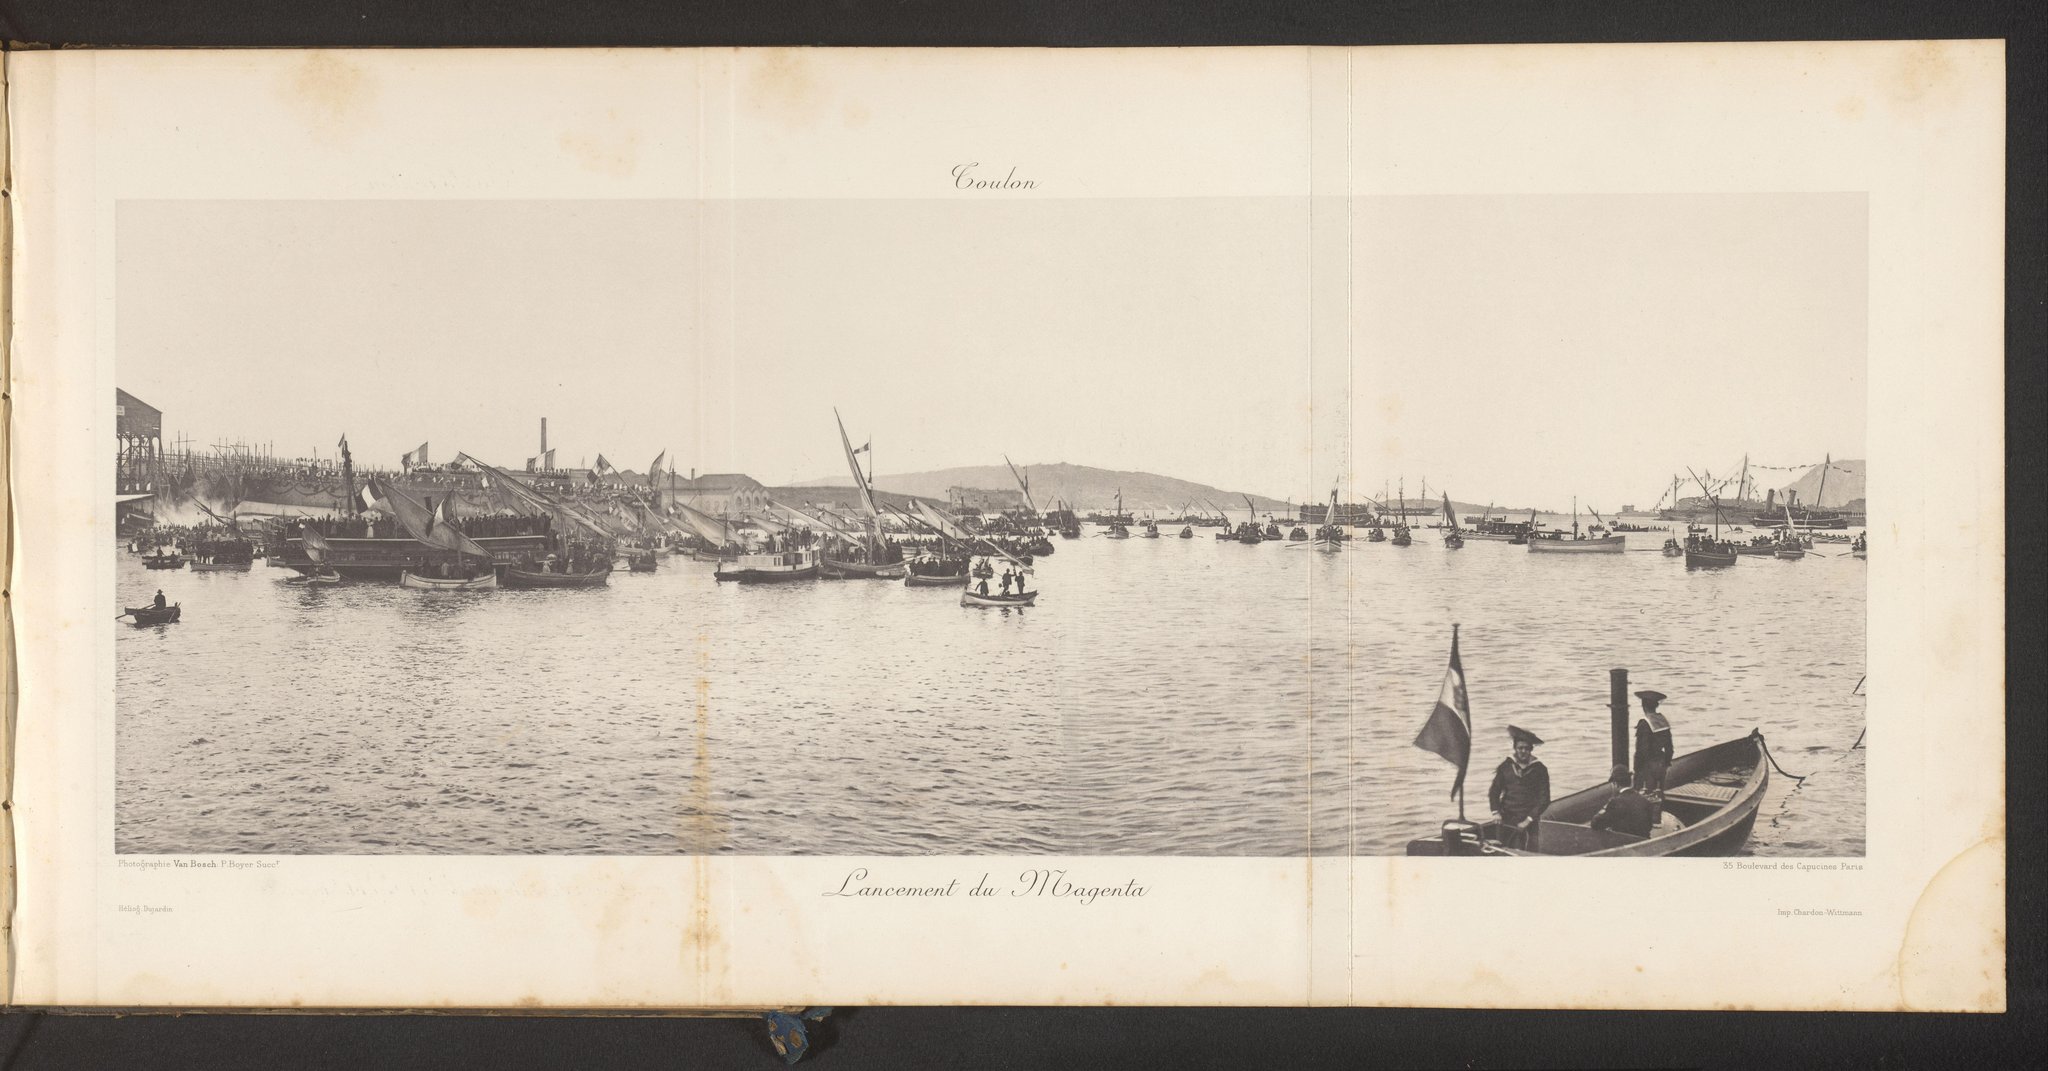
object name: photomechanical print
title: Schepen in de haven van Toulon tijdens de tewaterlating van de Magenta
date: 1890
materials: paper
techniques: photoaquatint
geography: toulon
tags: harbour, launching a ship, toulon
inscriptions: inscription: ‘Toulon’, inscription: ‘35 Boulevard des Capucines Paris’